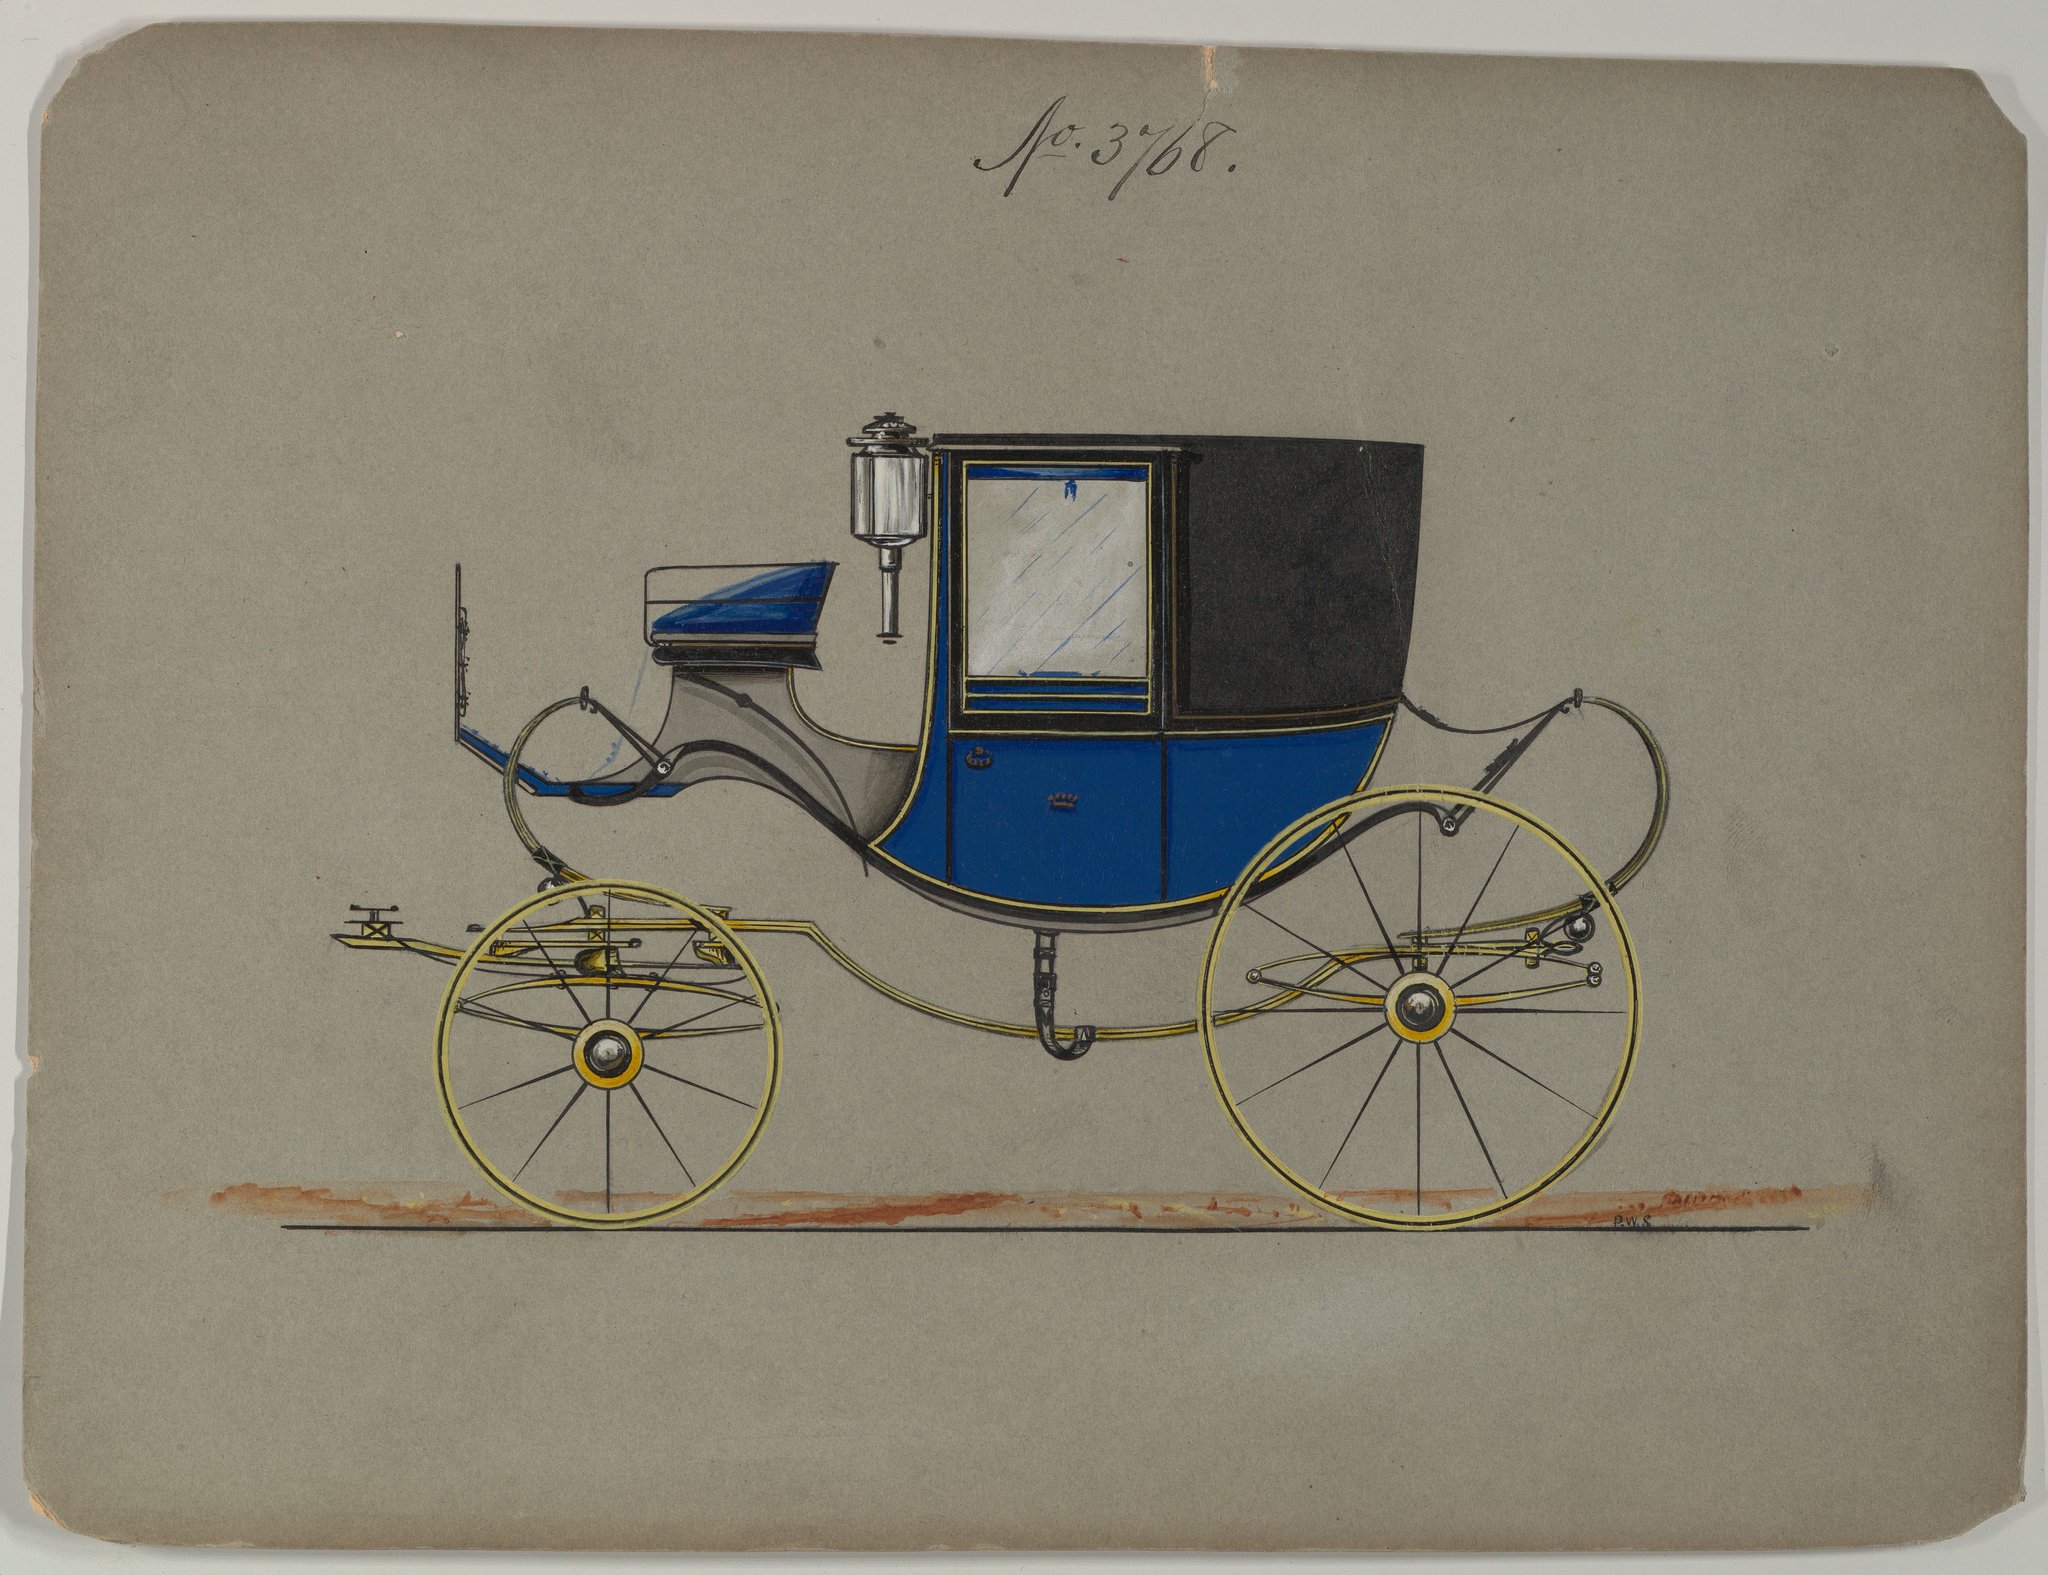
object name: drawing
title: D'Orsay #3768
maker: brewster & co.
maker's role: manufacturer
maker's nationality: american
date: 1882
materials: gouache, gum arabic, ink, watercolor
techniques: pen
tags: carriages